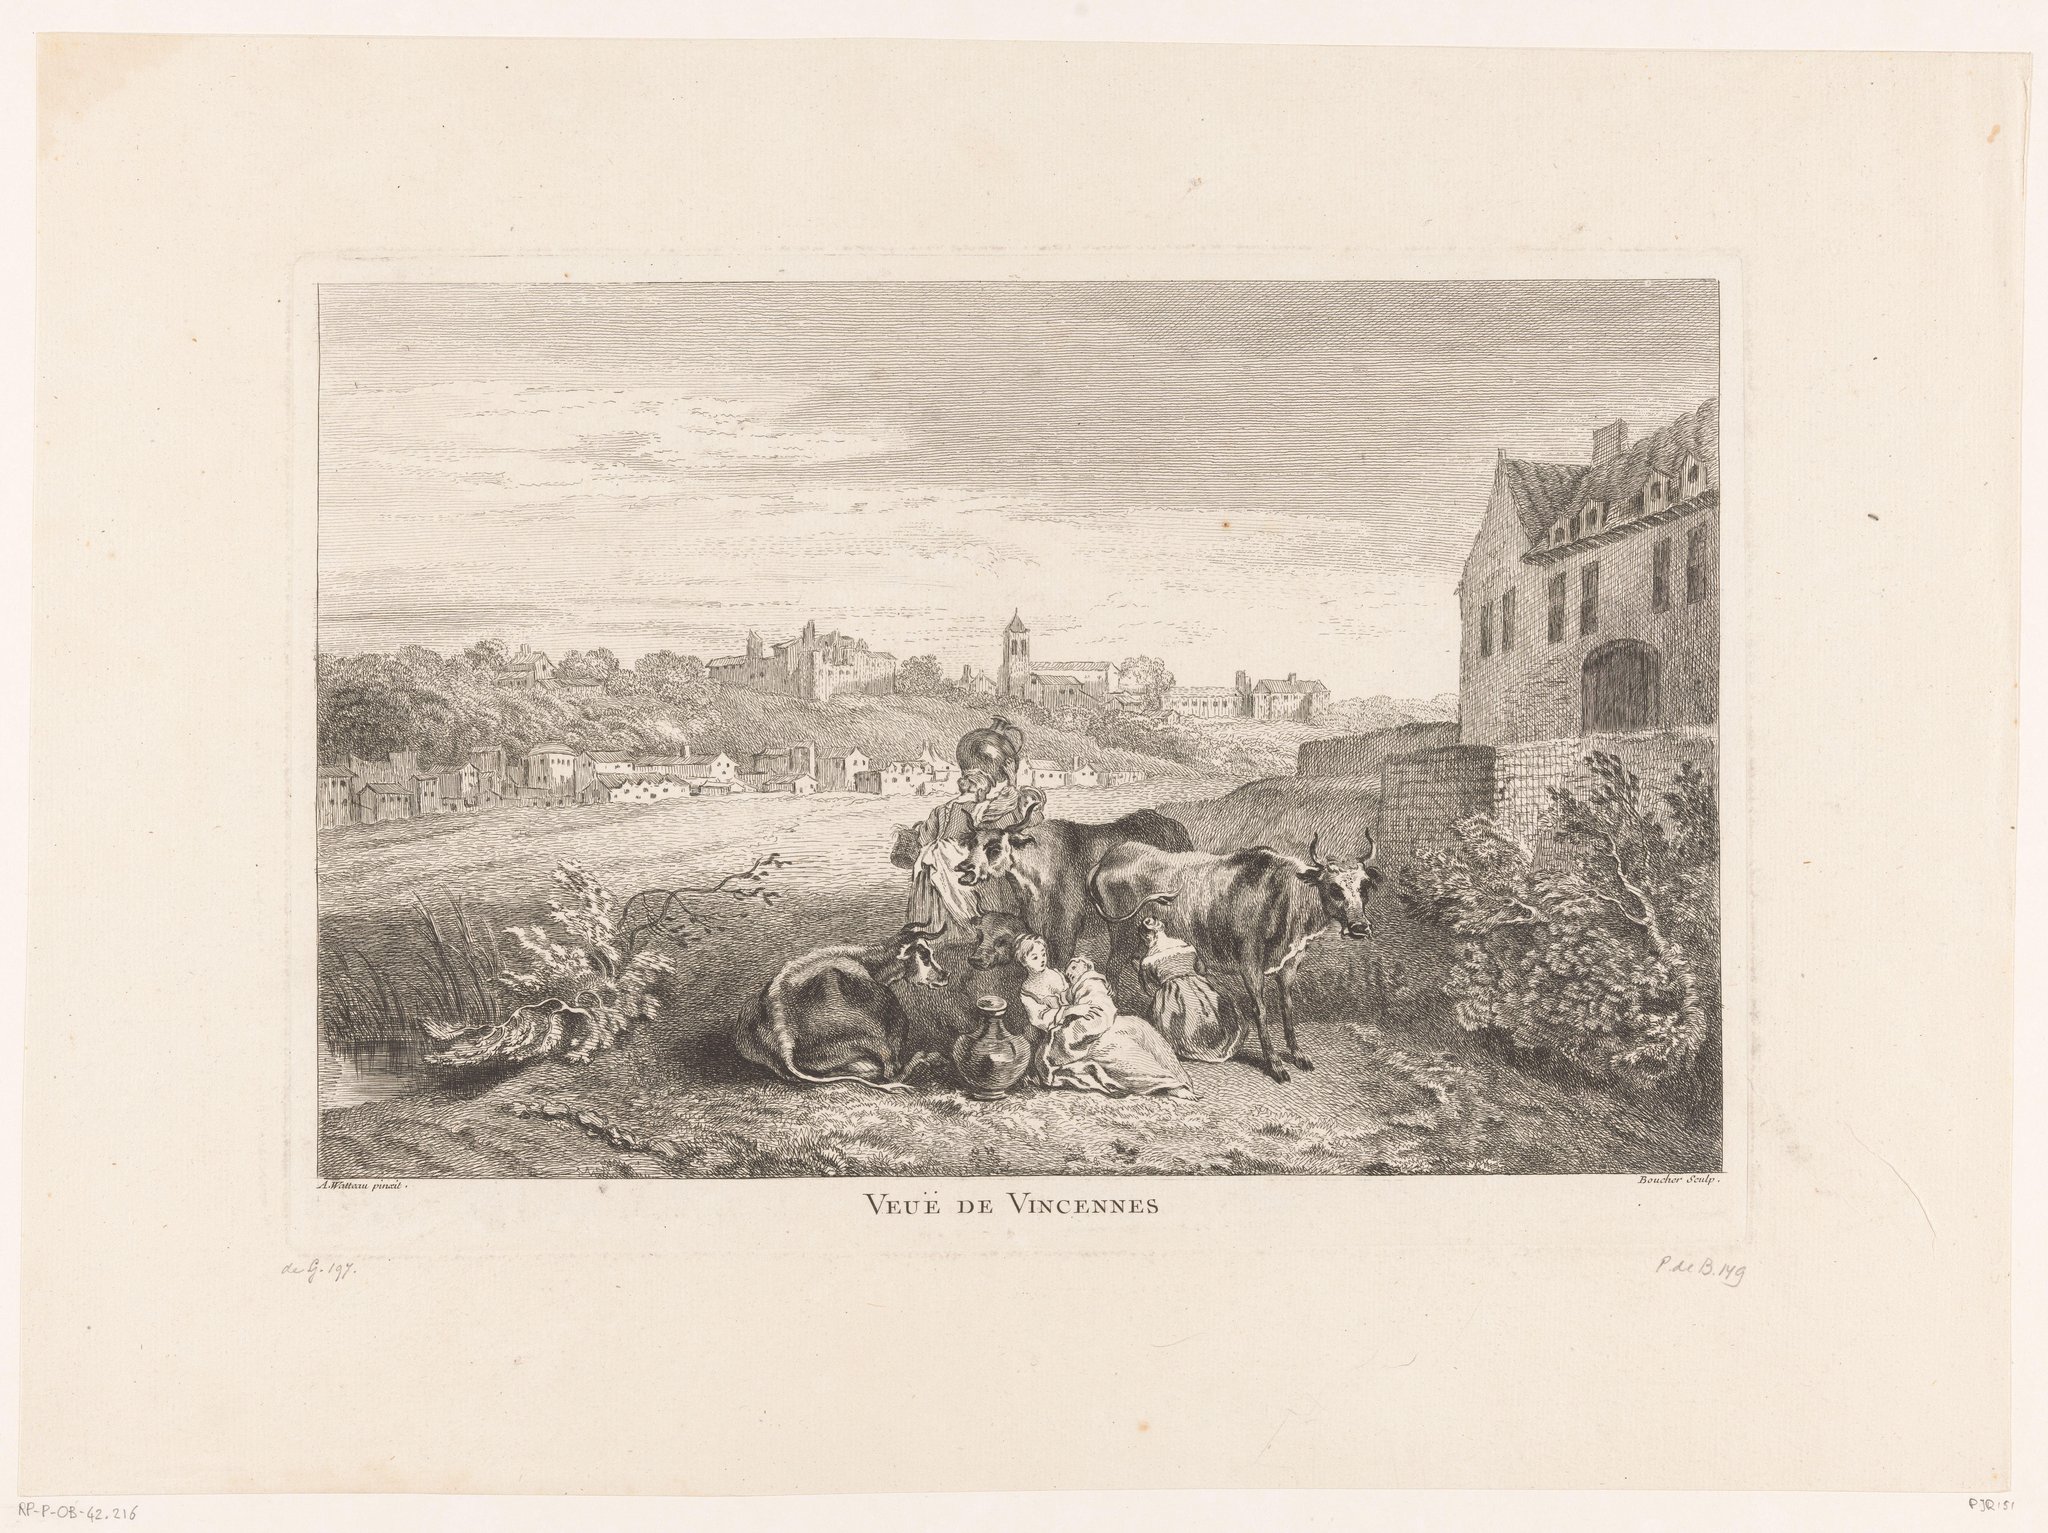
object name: print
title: Gezicht op Vincennes met koeien en figuren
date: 1727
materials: paper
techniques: engraving, etching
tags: cow, city-view in general; 'veduta', landscapes (+ landscape with figures, staffage)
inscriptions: collector's mark: Lugt 2228